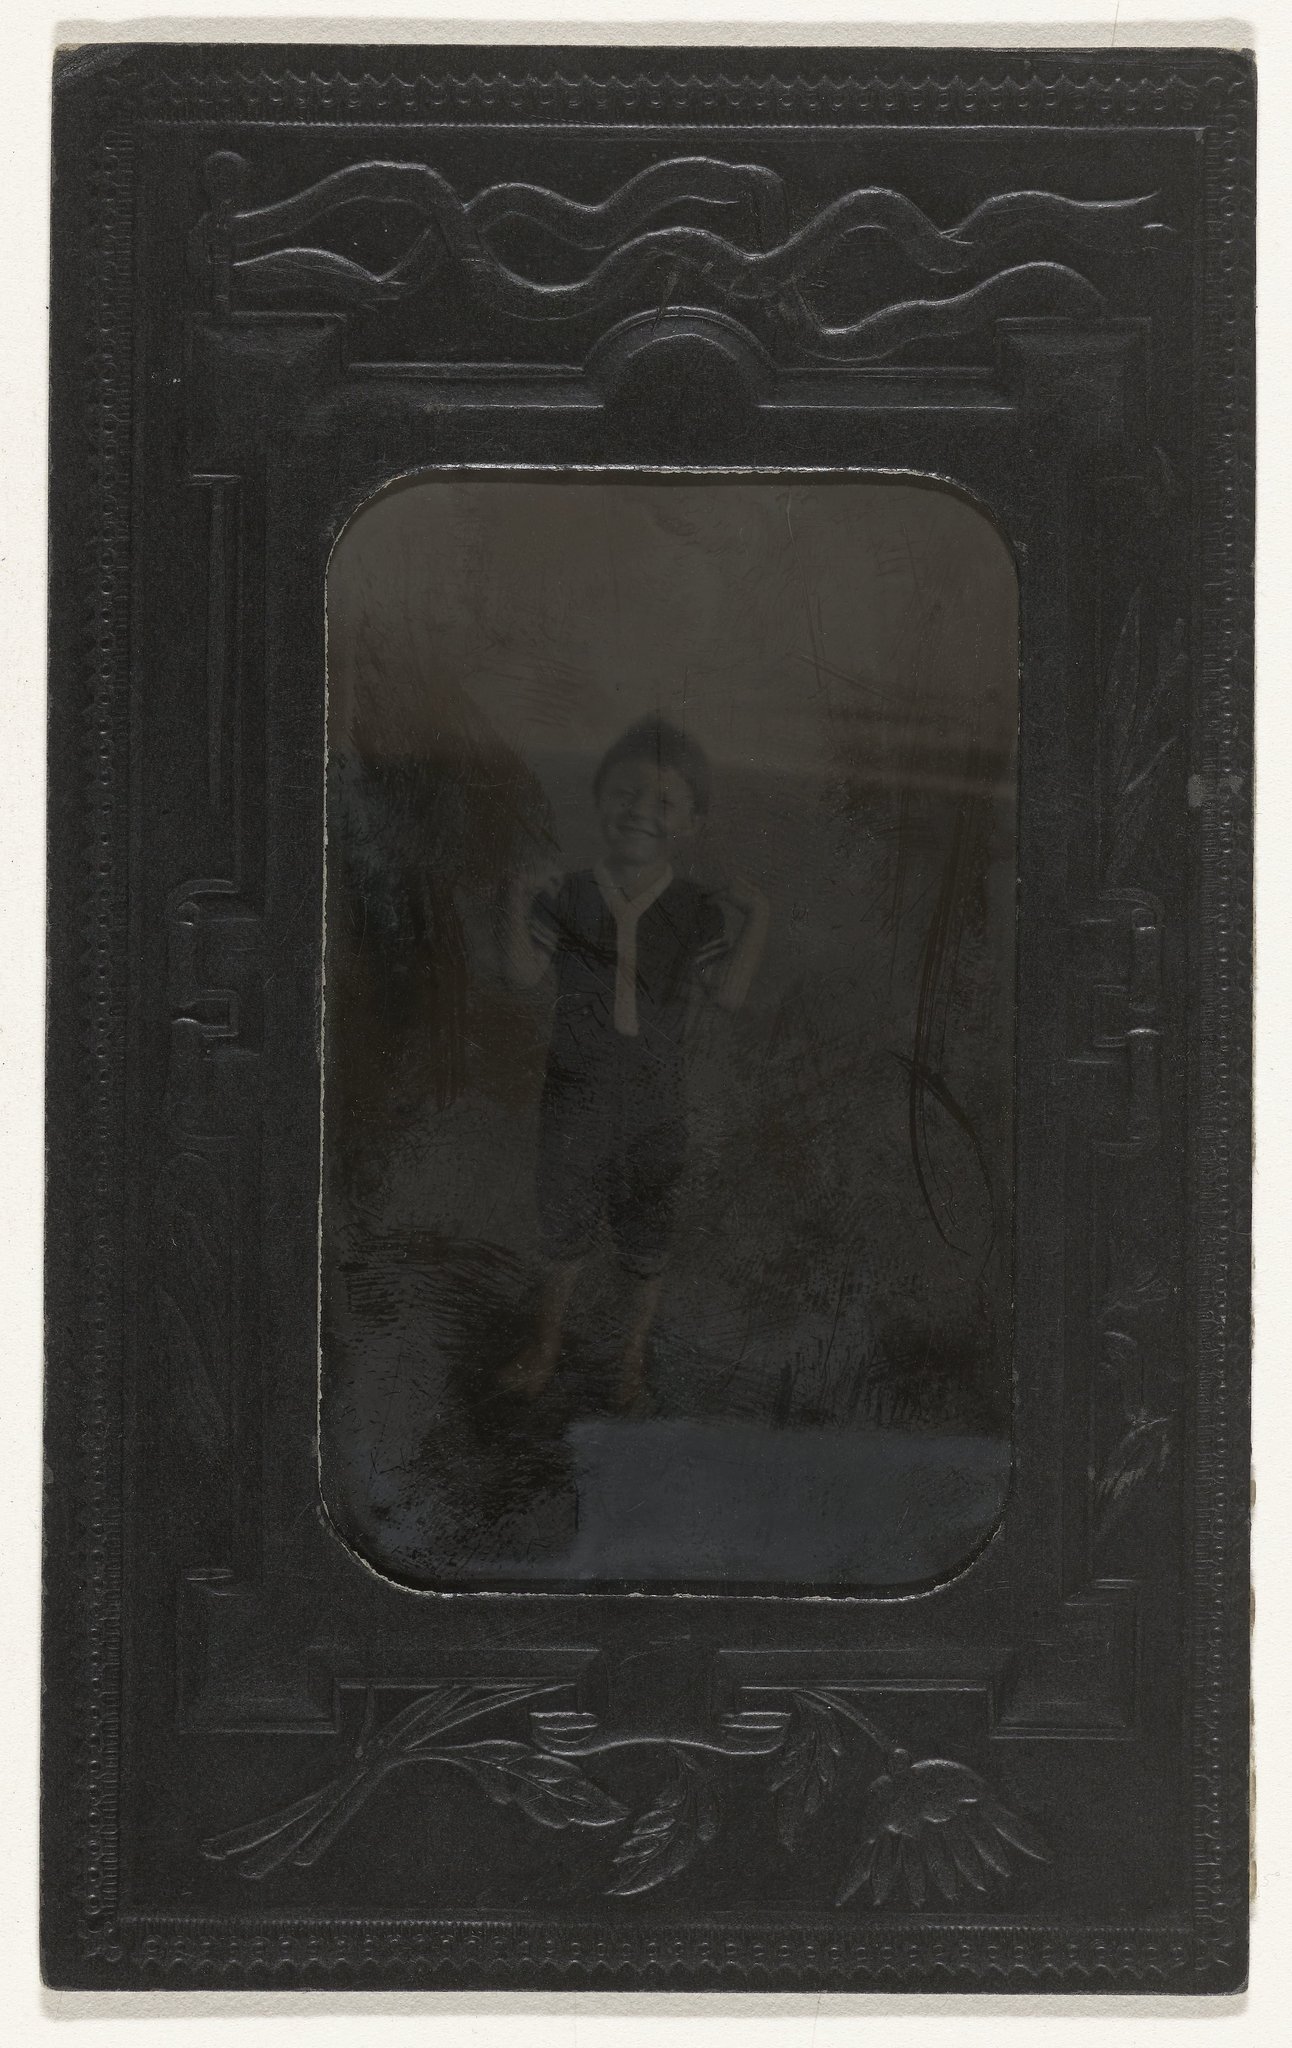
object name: photograph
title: Portret van een jongen op het strand, met de zee op de achtergrond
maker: Anonymous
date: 1890-1920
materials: metal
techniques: ferrotyping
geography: united states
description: Portret van een jongen op het strand, met de zee op de achtergrond, in kartonnen passepartout.